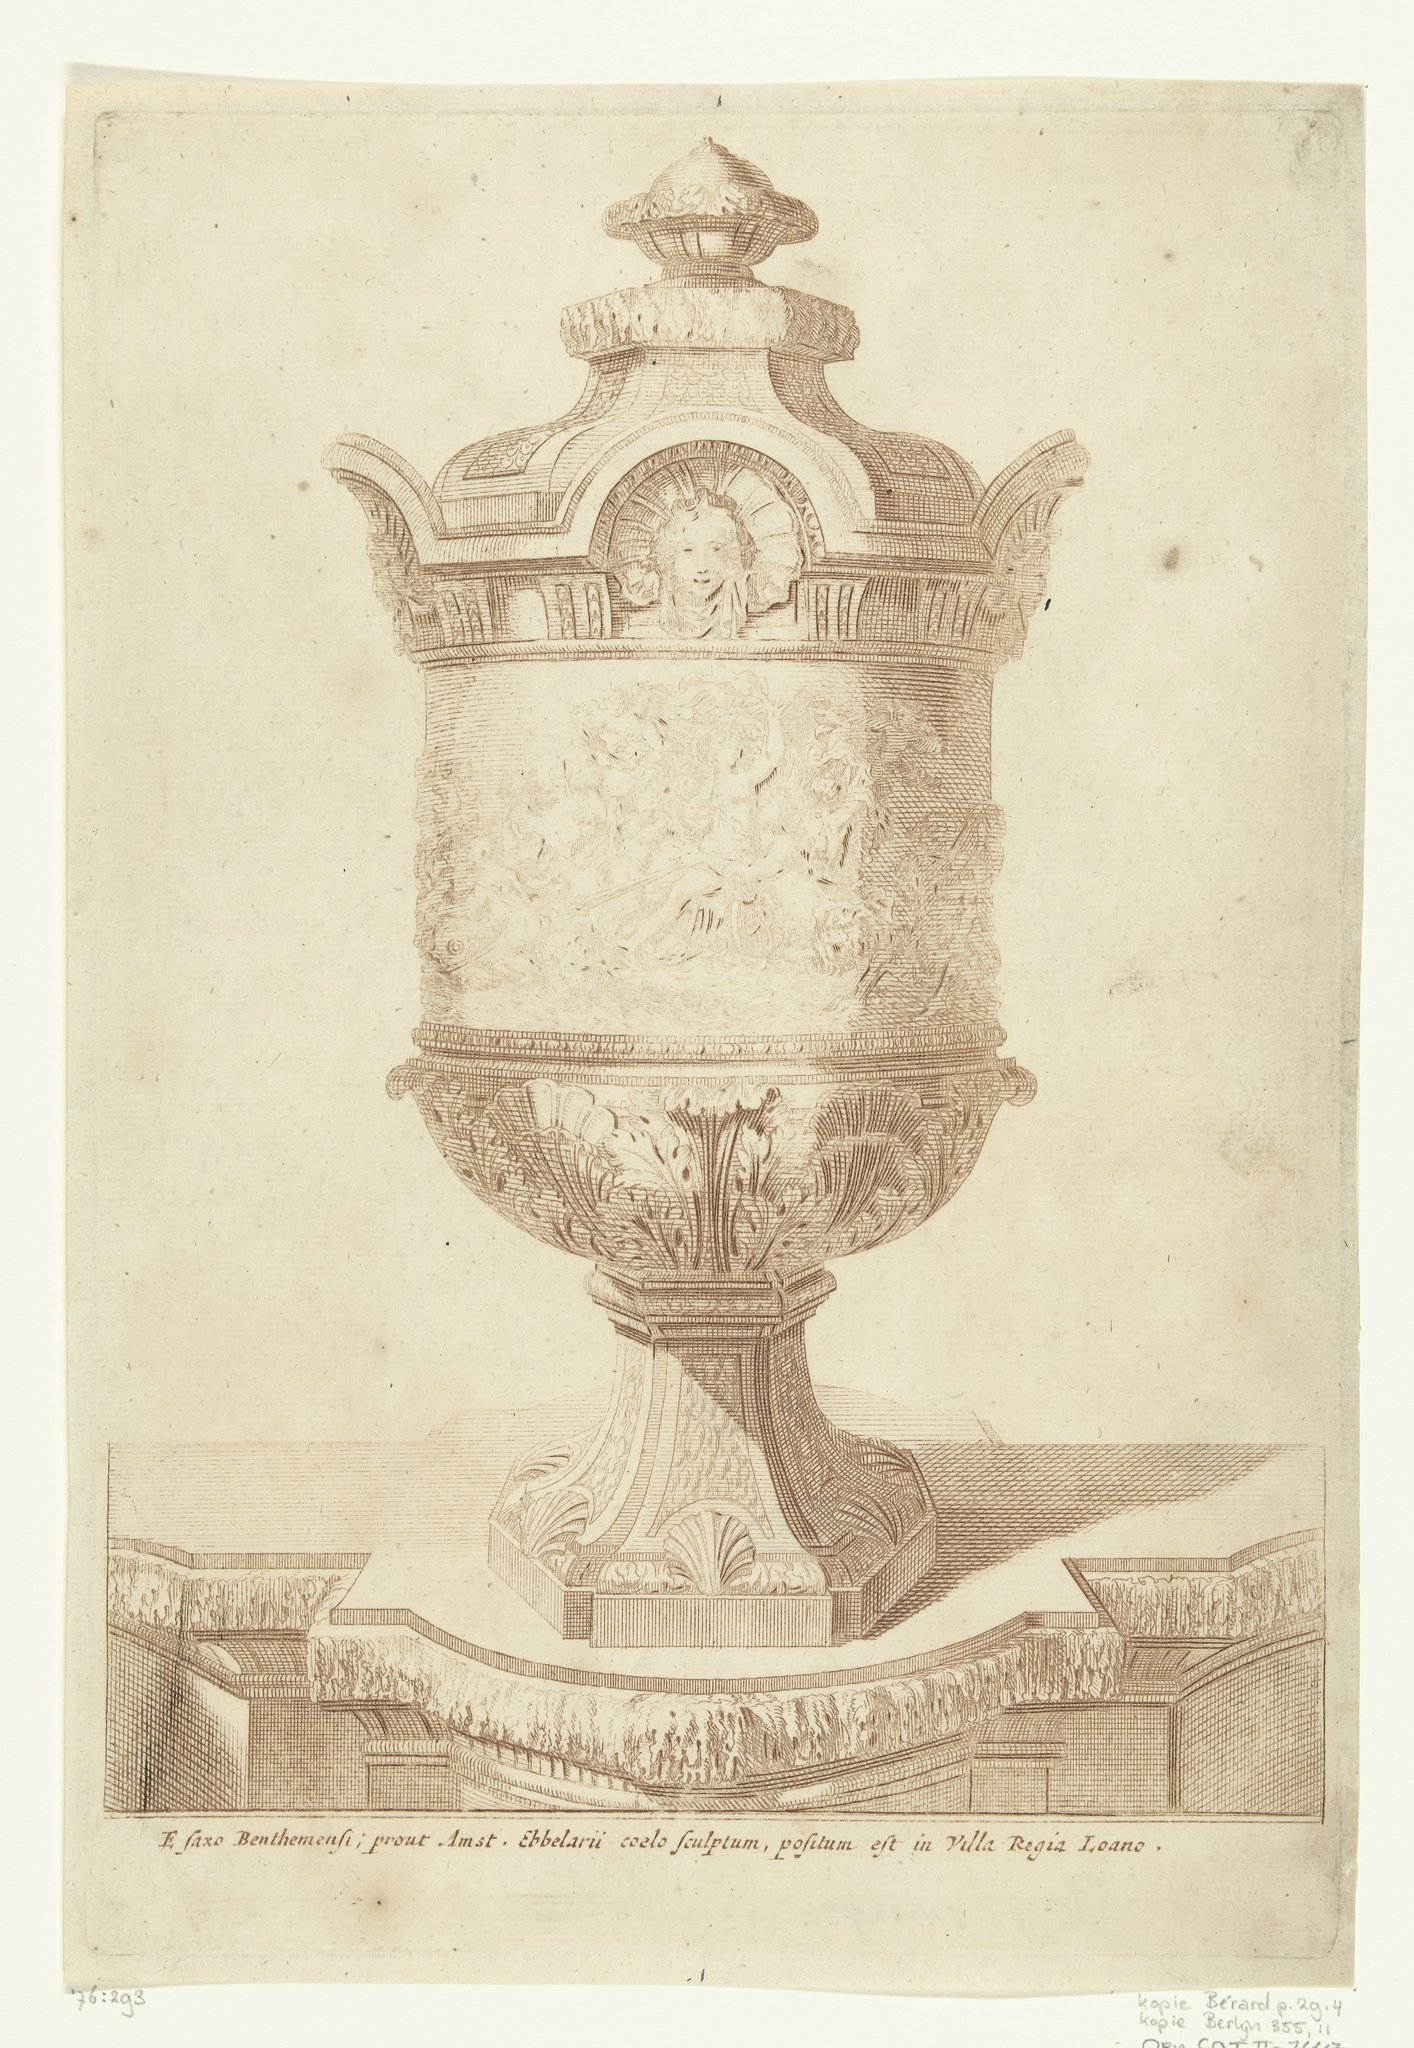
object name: ornament print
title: Vaas met de triomf van Amphitrite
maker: Anonymous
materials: paper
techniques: etching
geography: netherlands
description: Vaas op een achthoekige voet met deksel. Op het cilindervormig lichaam van de vaas de triomf van Amphitrite. In de ondermarge een Latijnse tekst. Kopie naar blad uit de serie Vasses de la Maison Royalle de L'oo. Uit serie van 6 bladen.